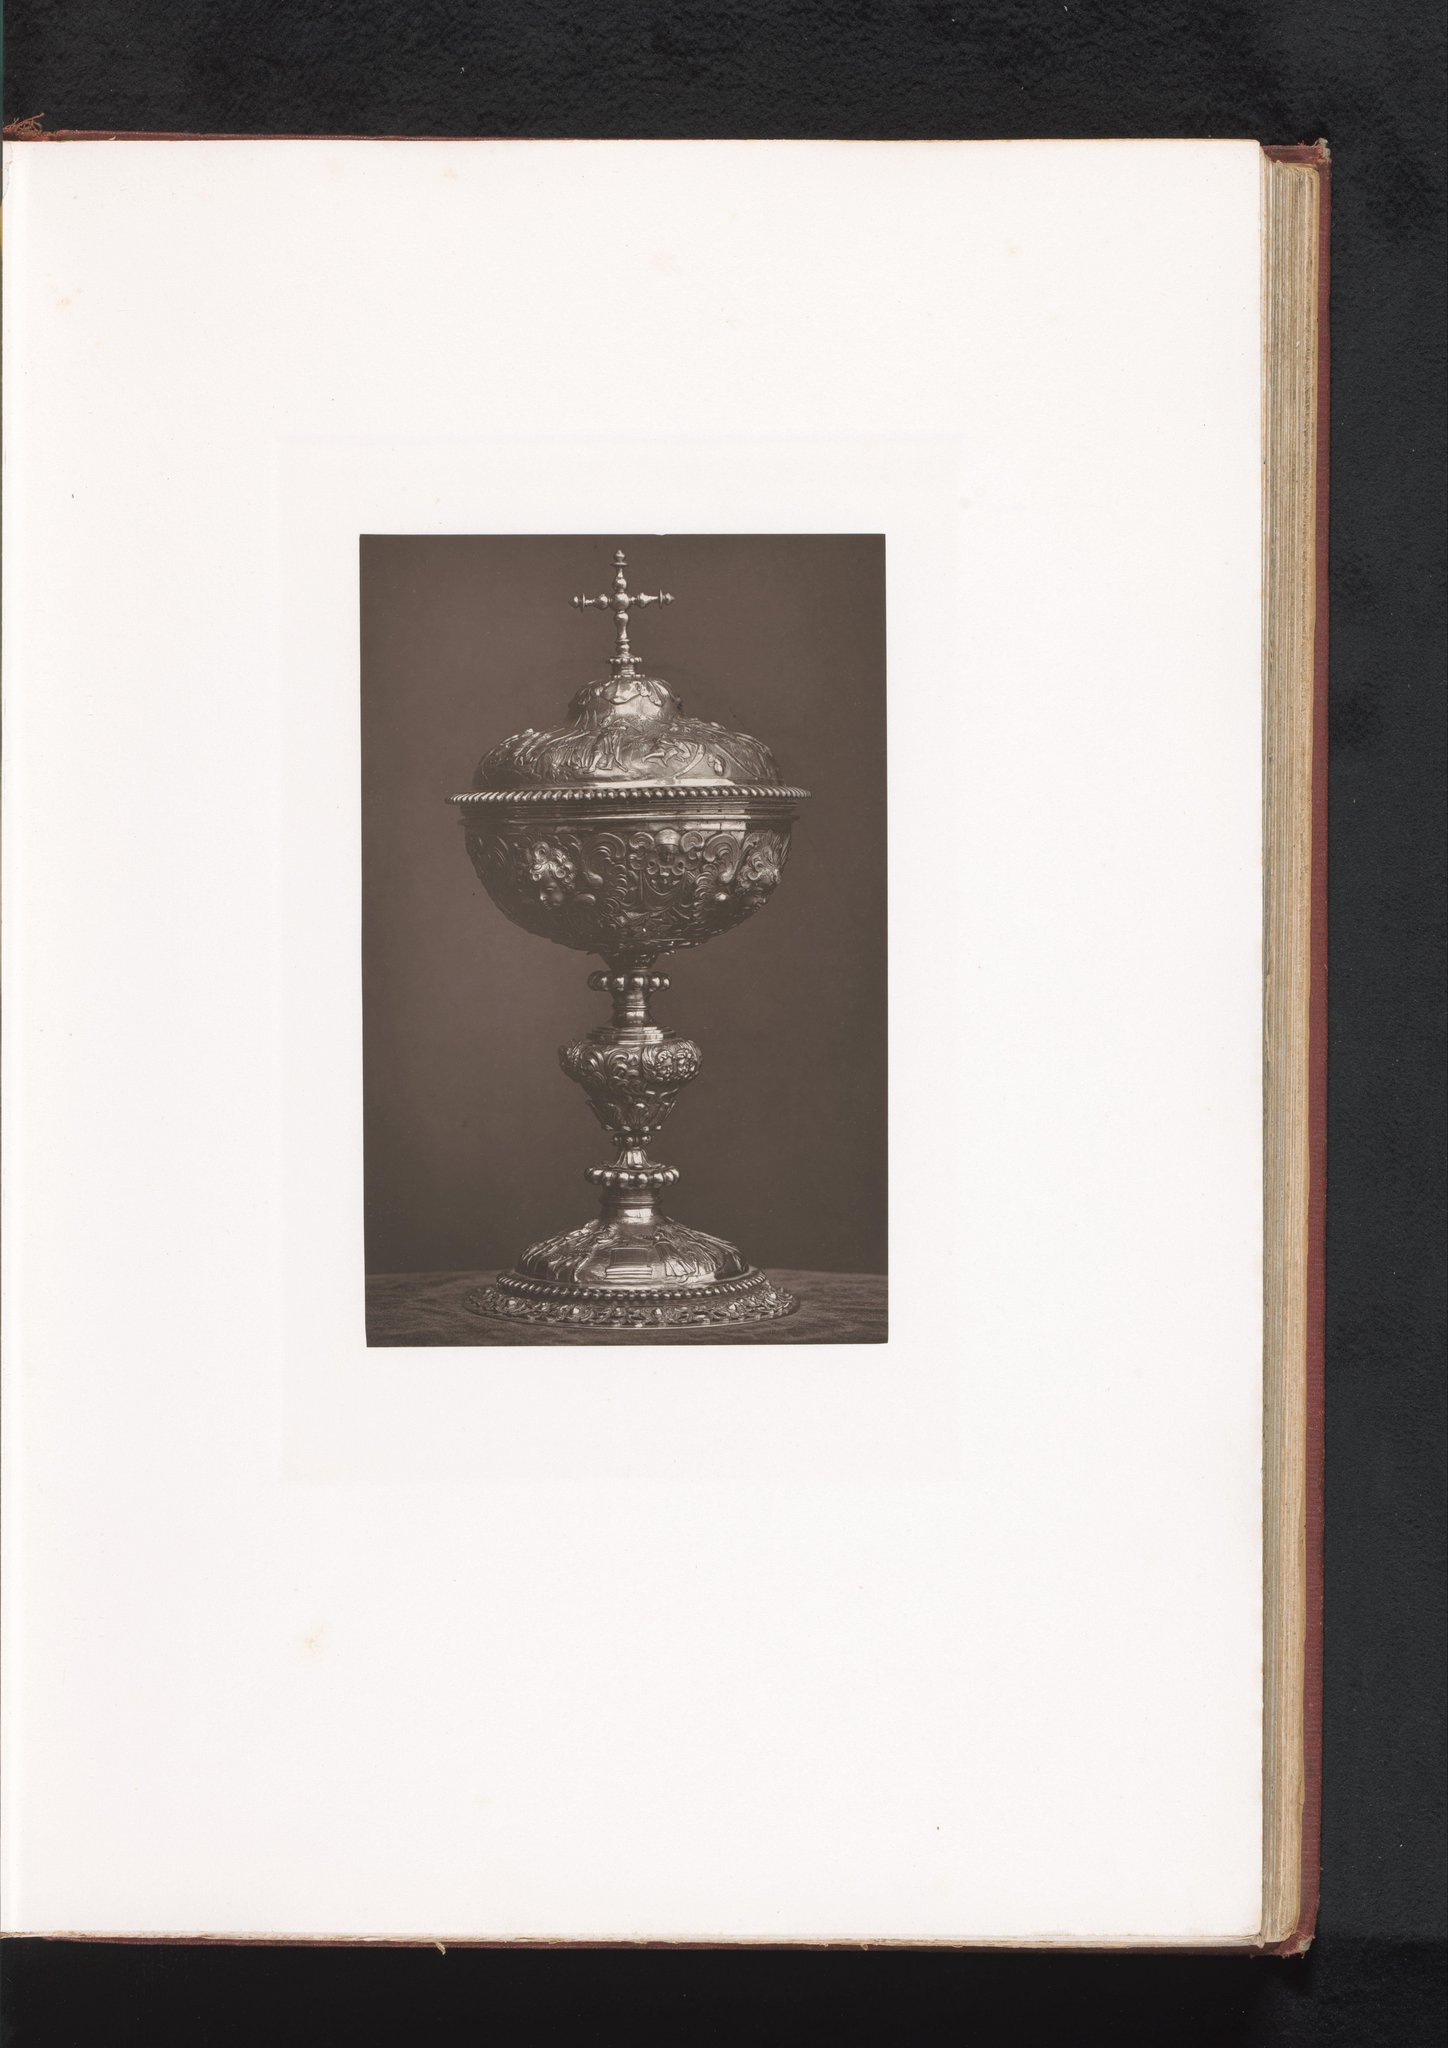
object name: photomechanical print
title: Ciborie van edelmetaal, opgesteld tijdens de Exposition Rétrospective van 1873 in Tours, Frankrijk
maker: gabriel blaise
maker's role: printer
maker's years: 1827-1897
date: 1873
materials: paper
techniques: woodburytype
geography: tours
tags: ciborium, temporary exhibition, 'salon'